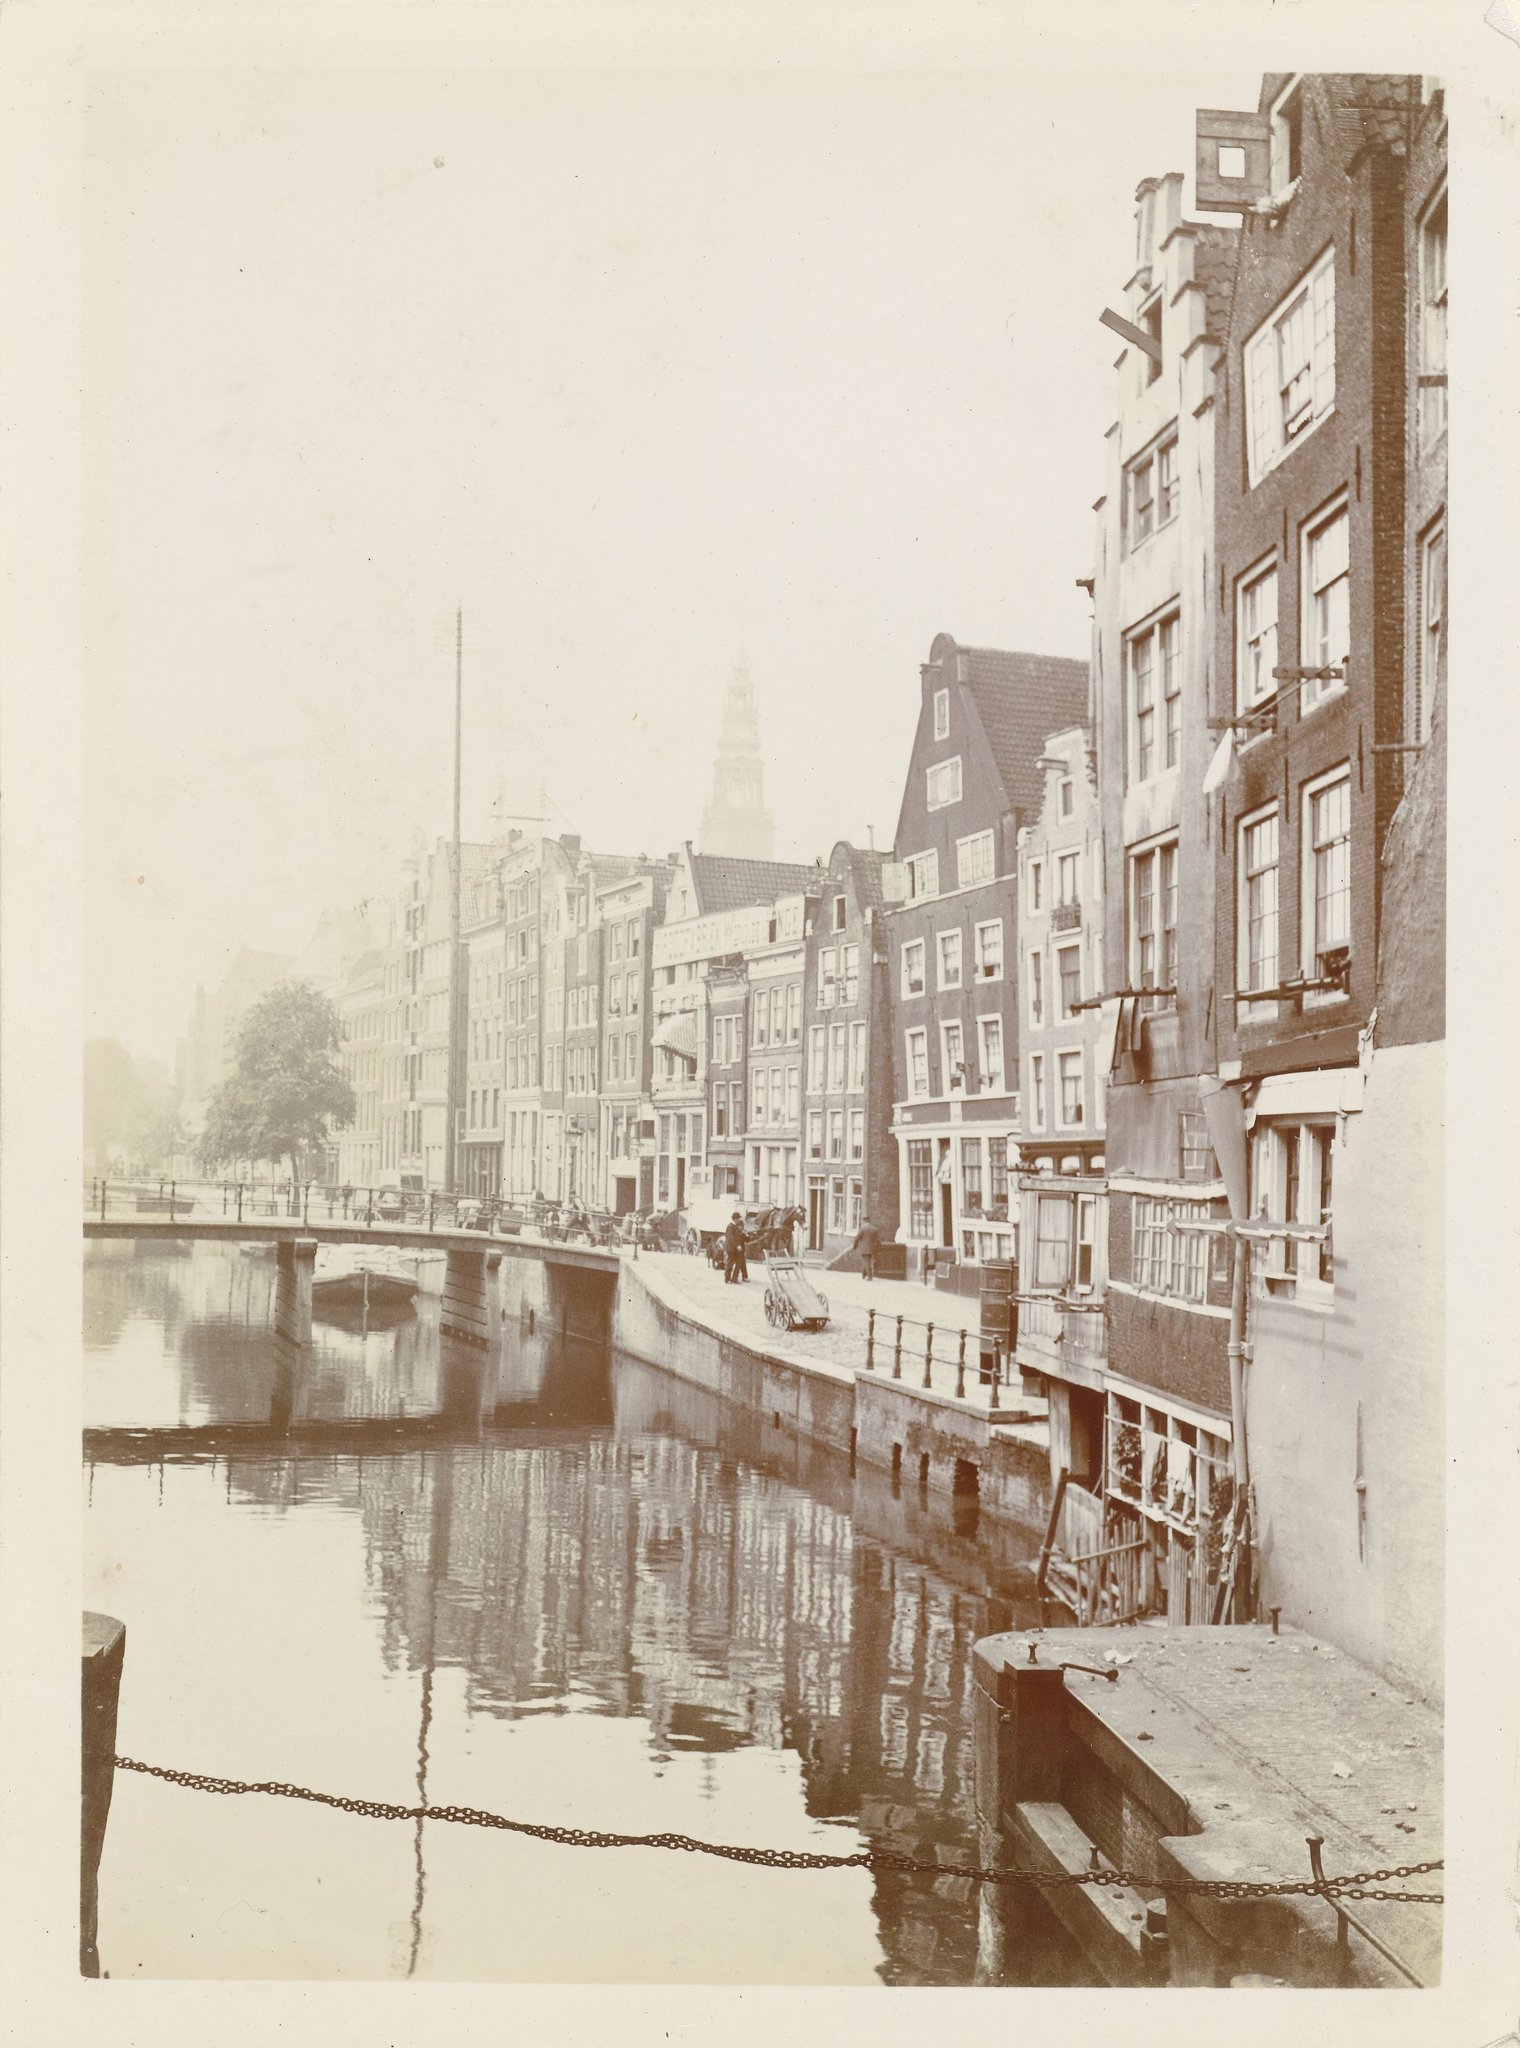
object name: photograph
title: Gezicht op de Oudezijds Voorburgwal, gezien vanaf de Zeedijk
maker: james higson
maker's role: politician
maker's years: 1862-1933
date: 1904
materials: paper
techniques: gelatin silver print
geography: amsterdam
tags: canals, waters (in city)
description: Op de achtergrond de toren van de Oude Kerk, Amsterdam.